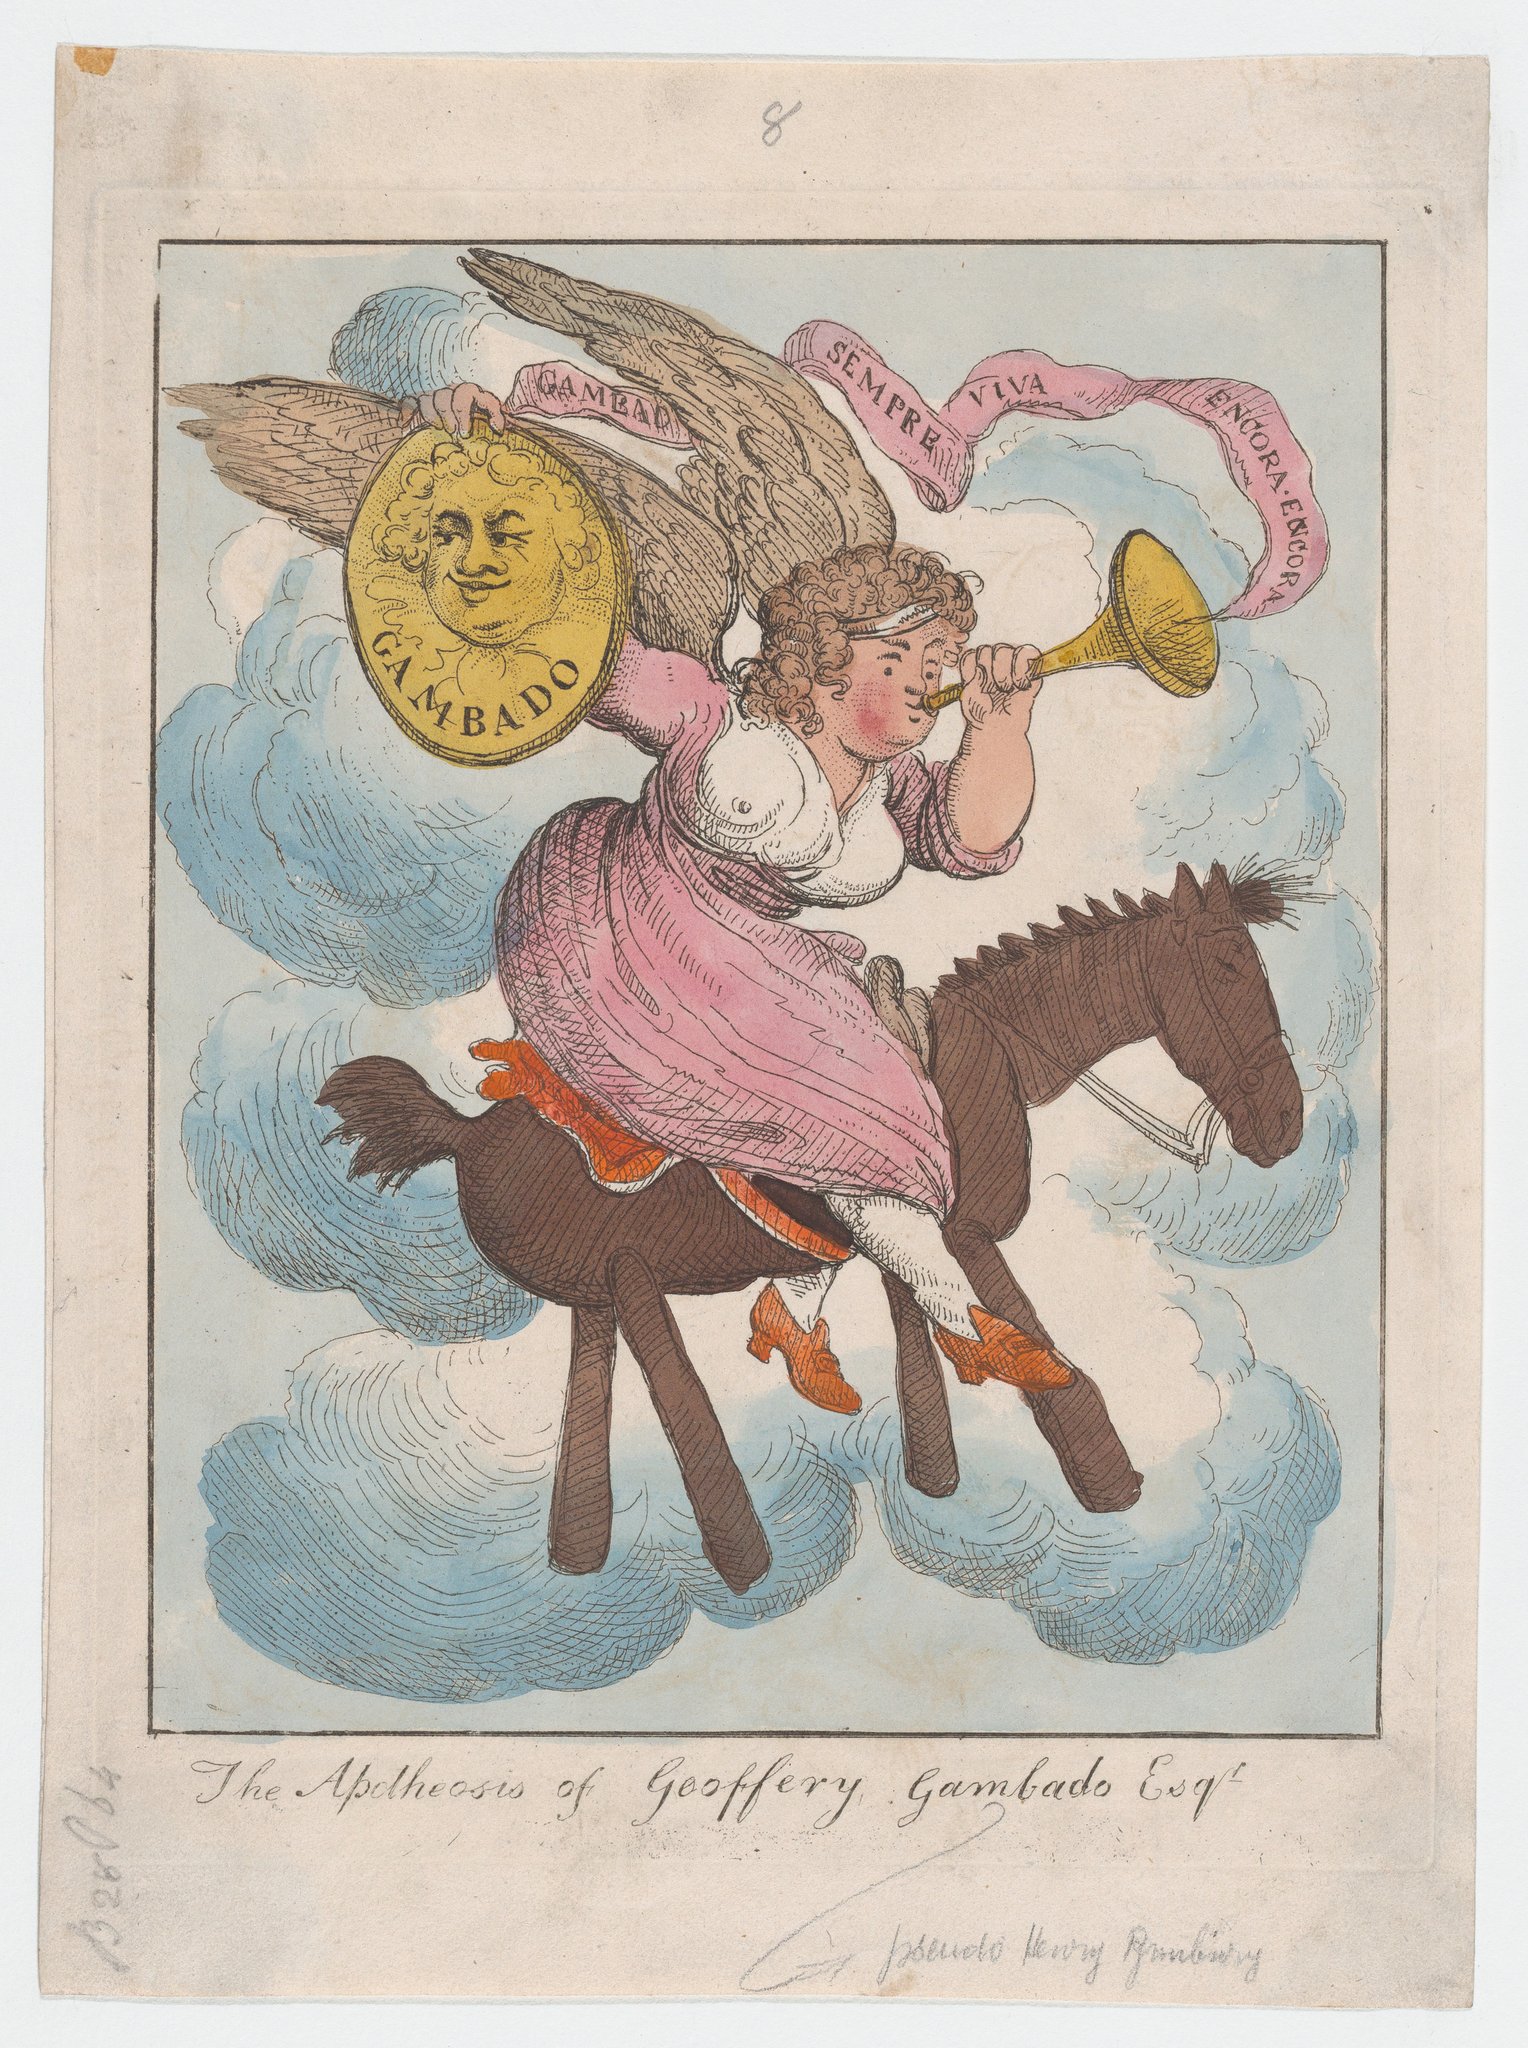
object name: print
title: The Apotheosis of Geoffery Gambade Esqr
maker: thomas rowlandson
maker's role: artist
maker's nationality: british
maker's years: 1757-1827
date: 1808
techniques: etching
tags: musical instruments,horses